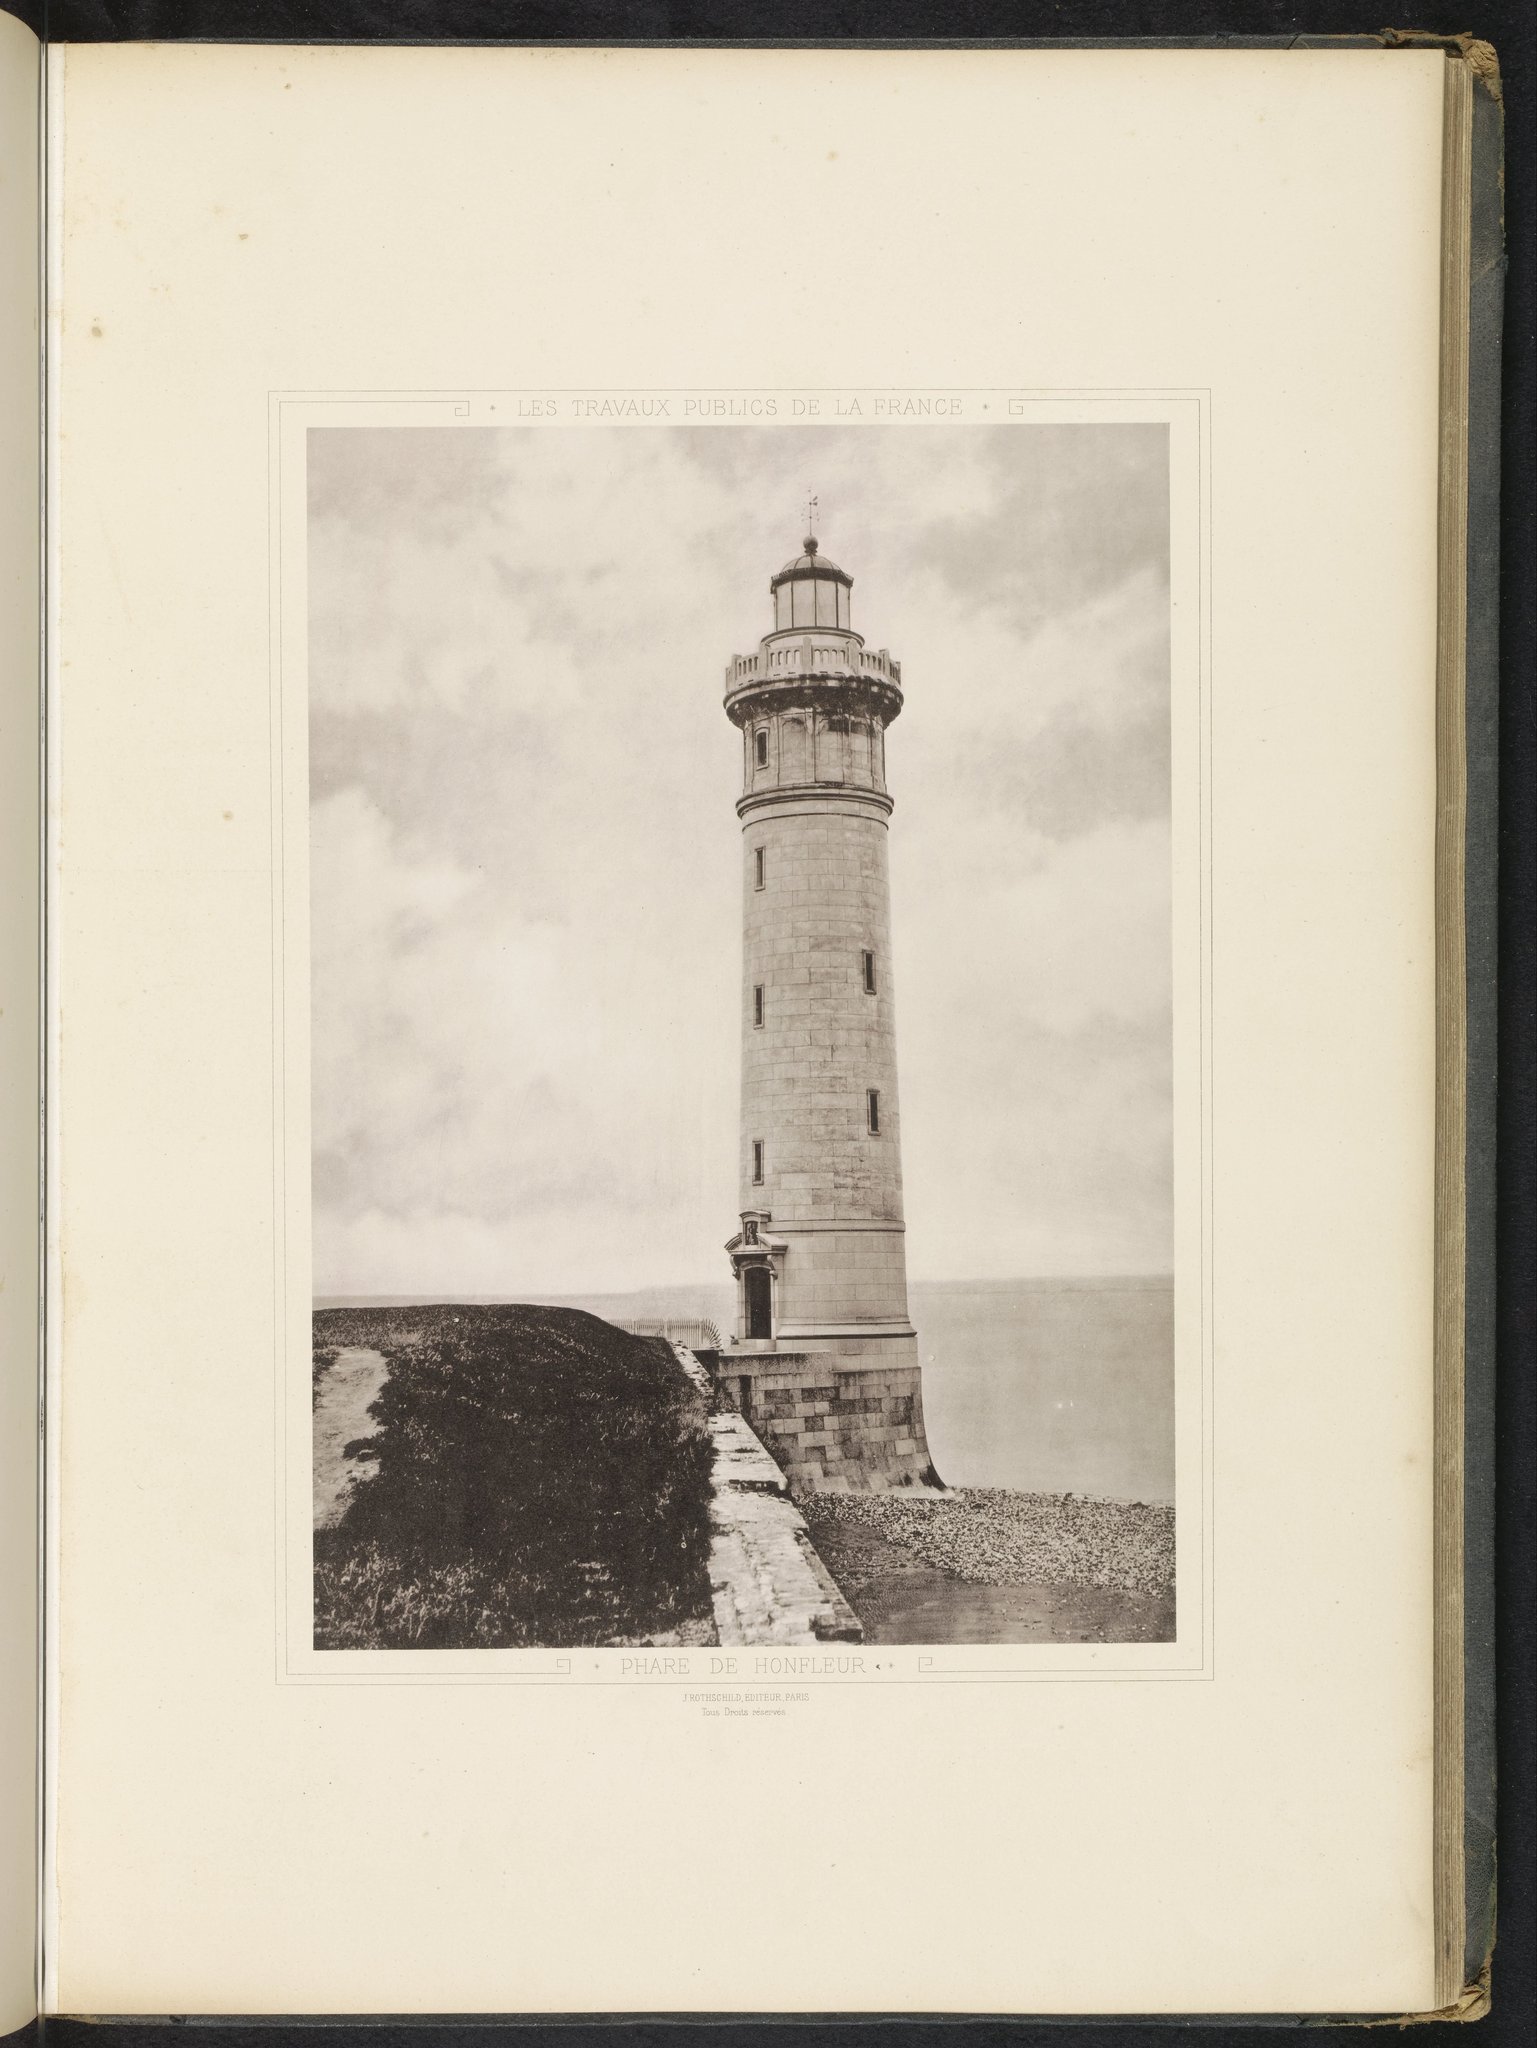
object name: page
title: Phare de Honfleur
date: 1873-1883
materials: paper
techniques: photograph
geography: paris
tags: lighthouse, lightship